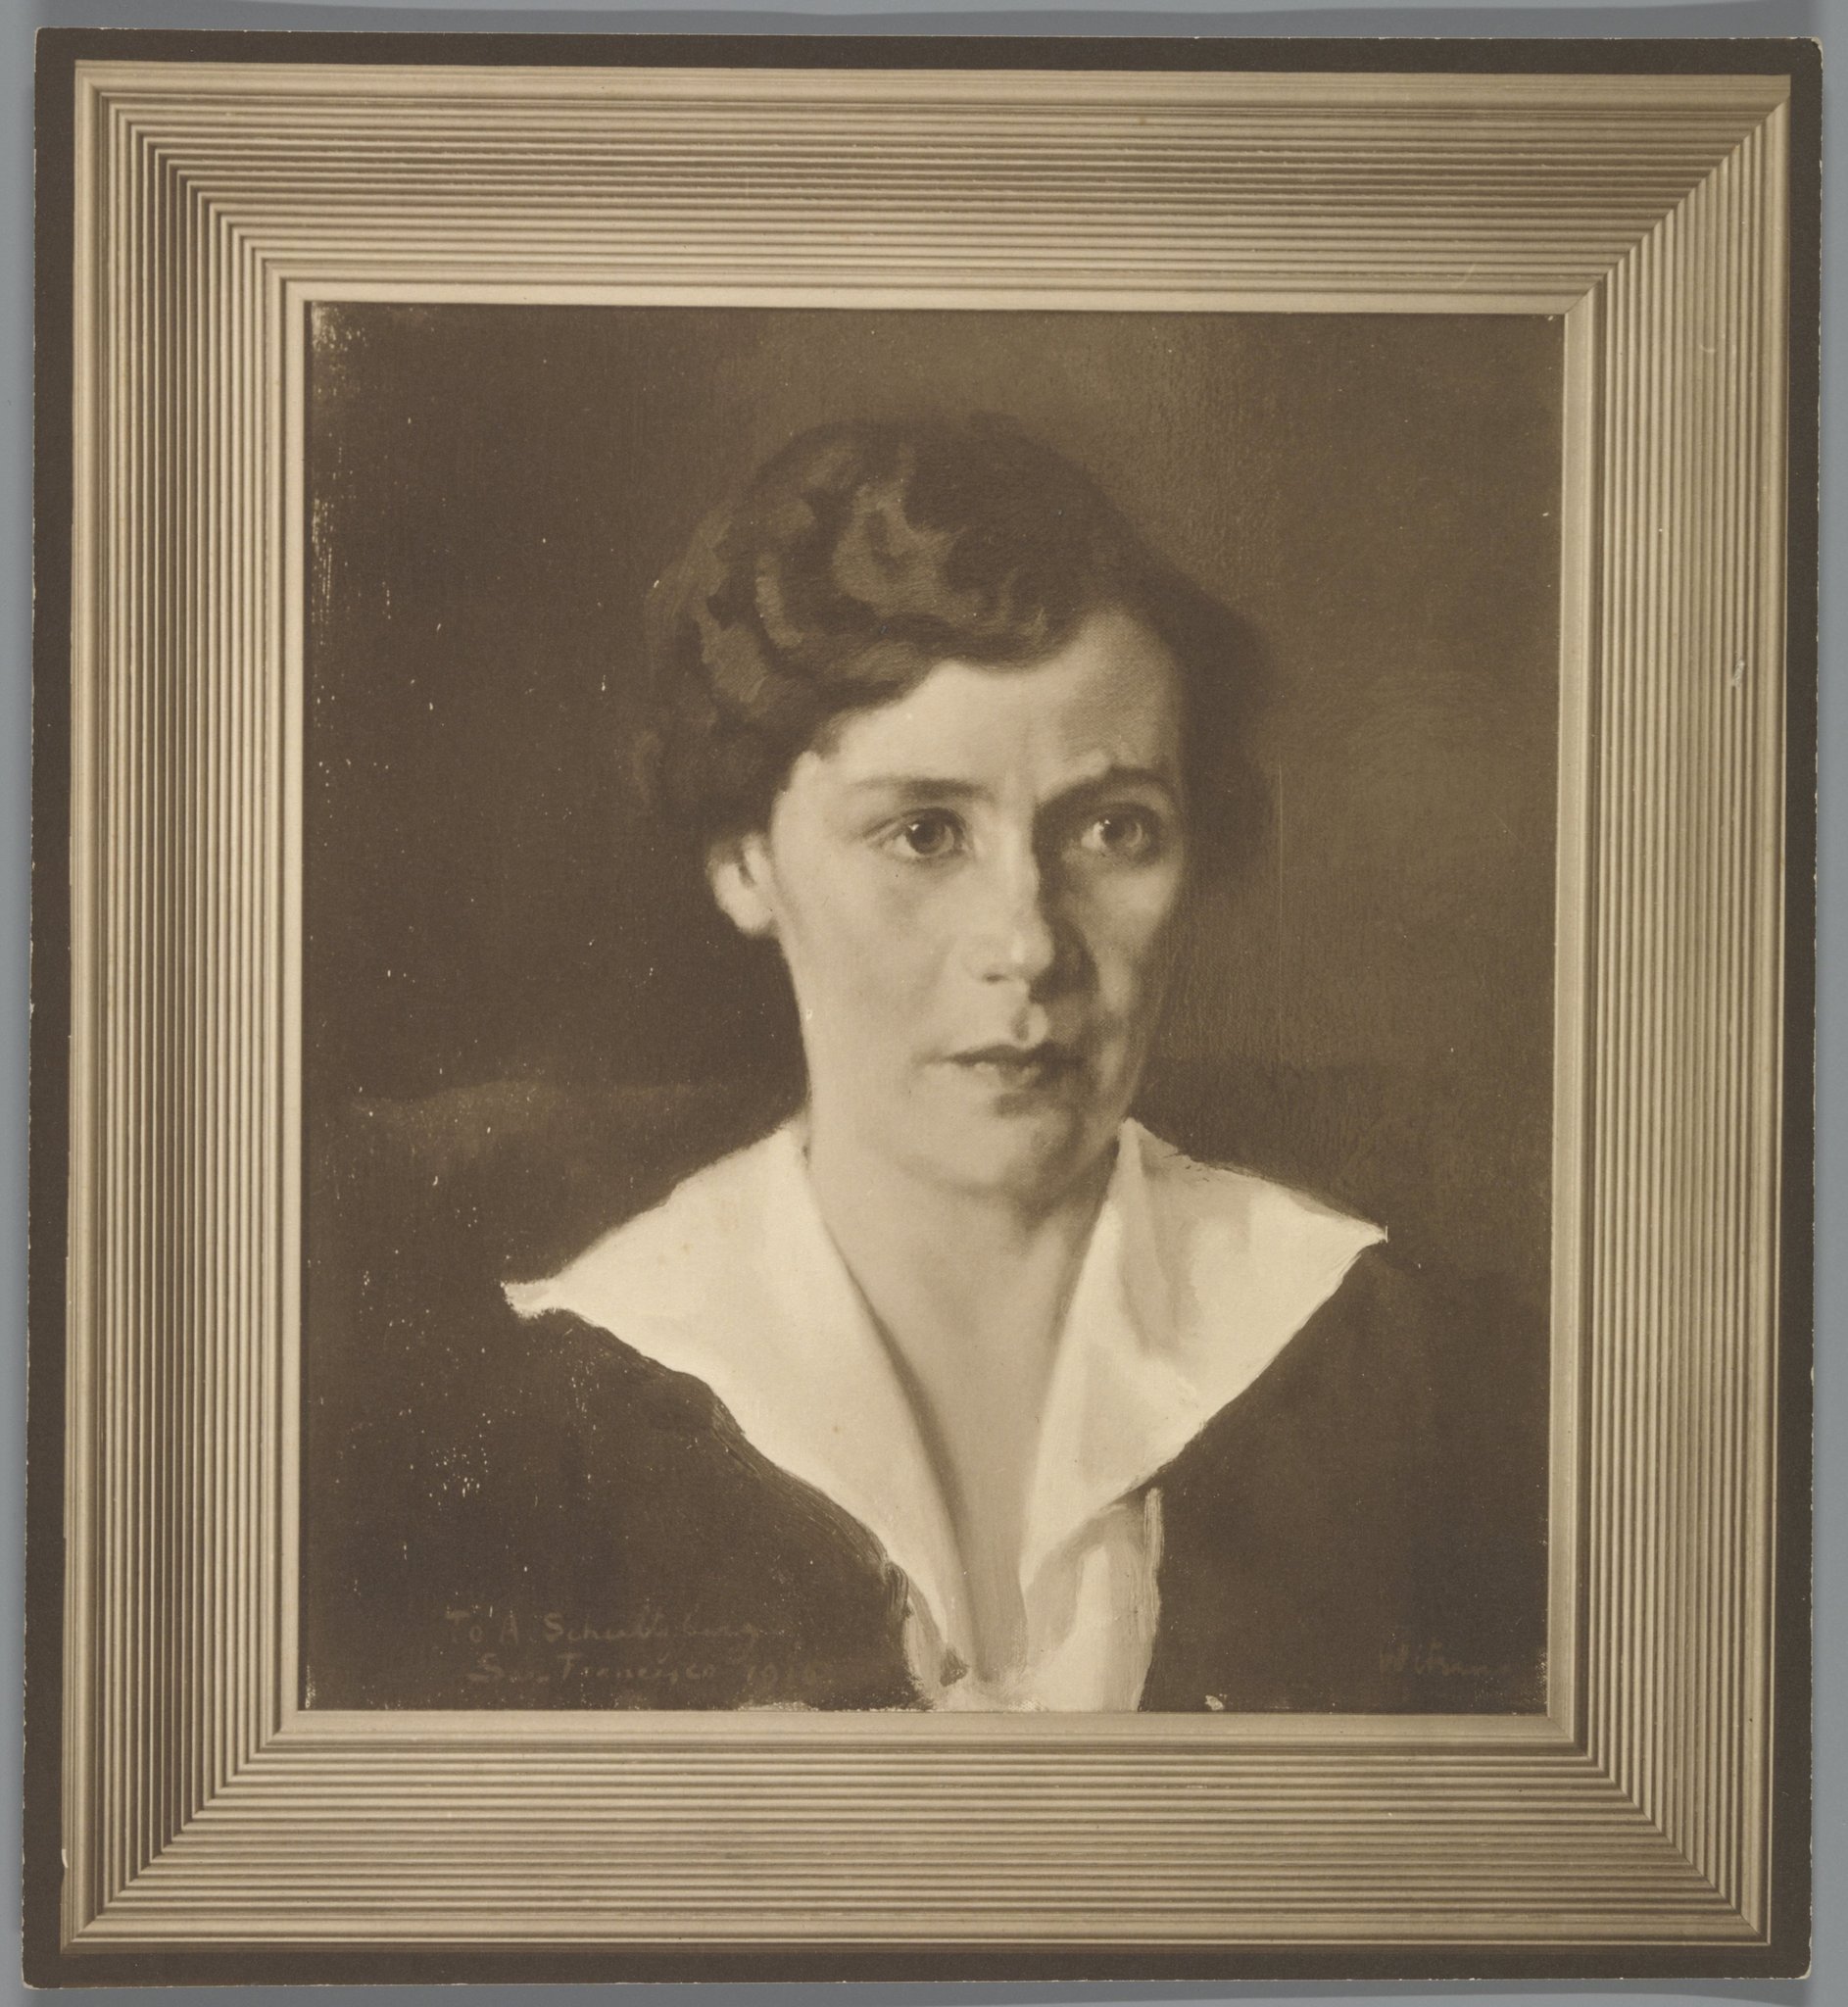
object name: photograph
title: Reproductie naar schilderij van Willem Witsen van een portret van mevrouw A. Schultzberg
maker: Anonymous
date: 1860-1915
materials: paper, photographic support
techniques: gelatin silver print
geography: netherlands